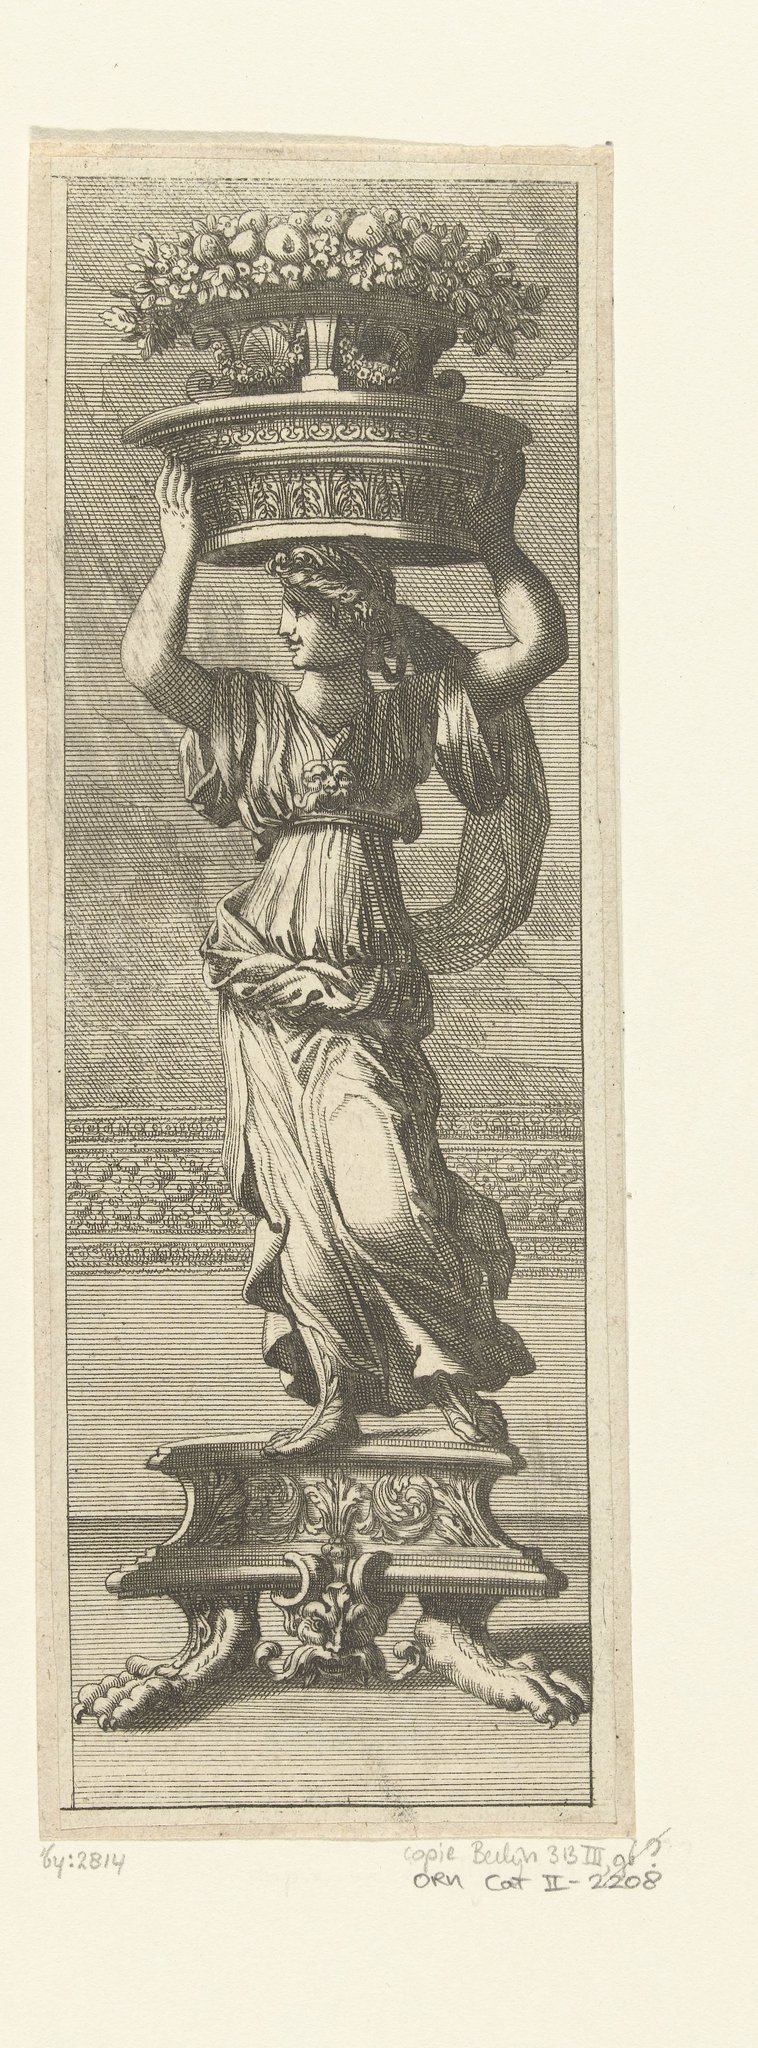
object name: print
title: Kaarsendrager in vorm van vrouw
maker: jean lepautre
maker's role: draughtsman, print maker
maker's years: 1618-1682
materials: paper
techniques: etching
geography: france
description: De vrouw draagt een fruitmand. Uit serie van 6 bladen.